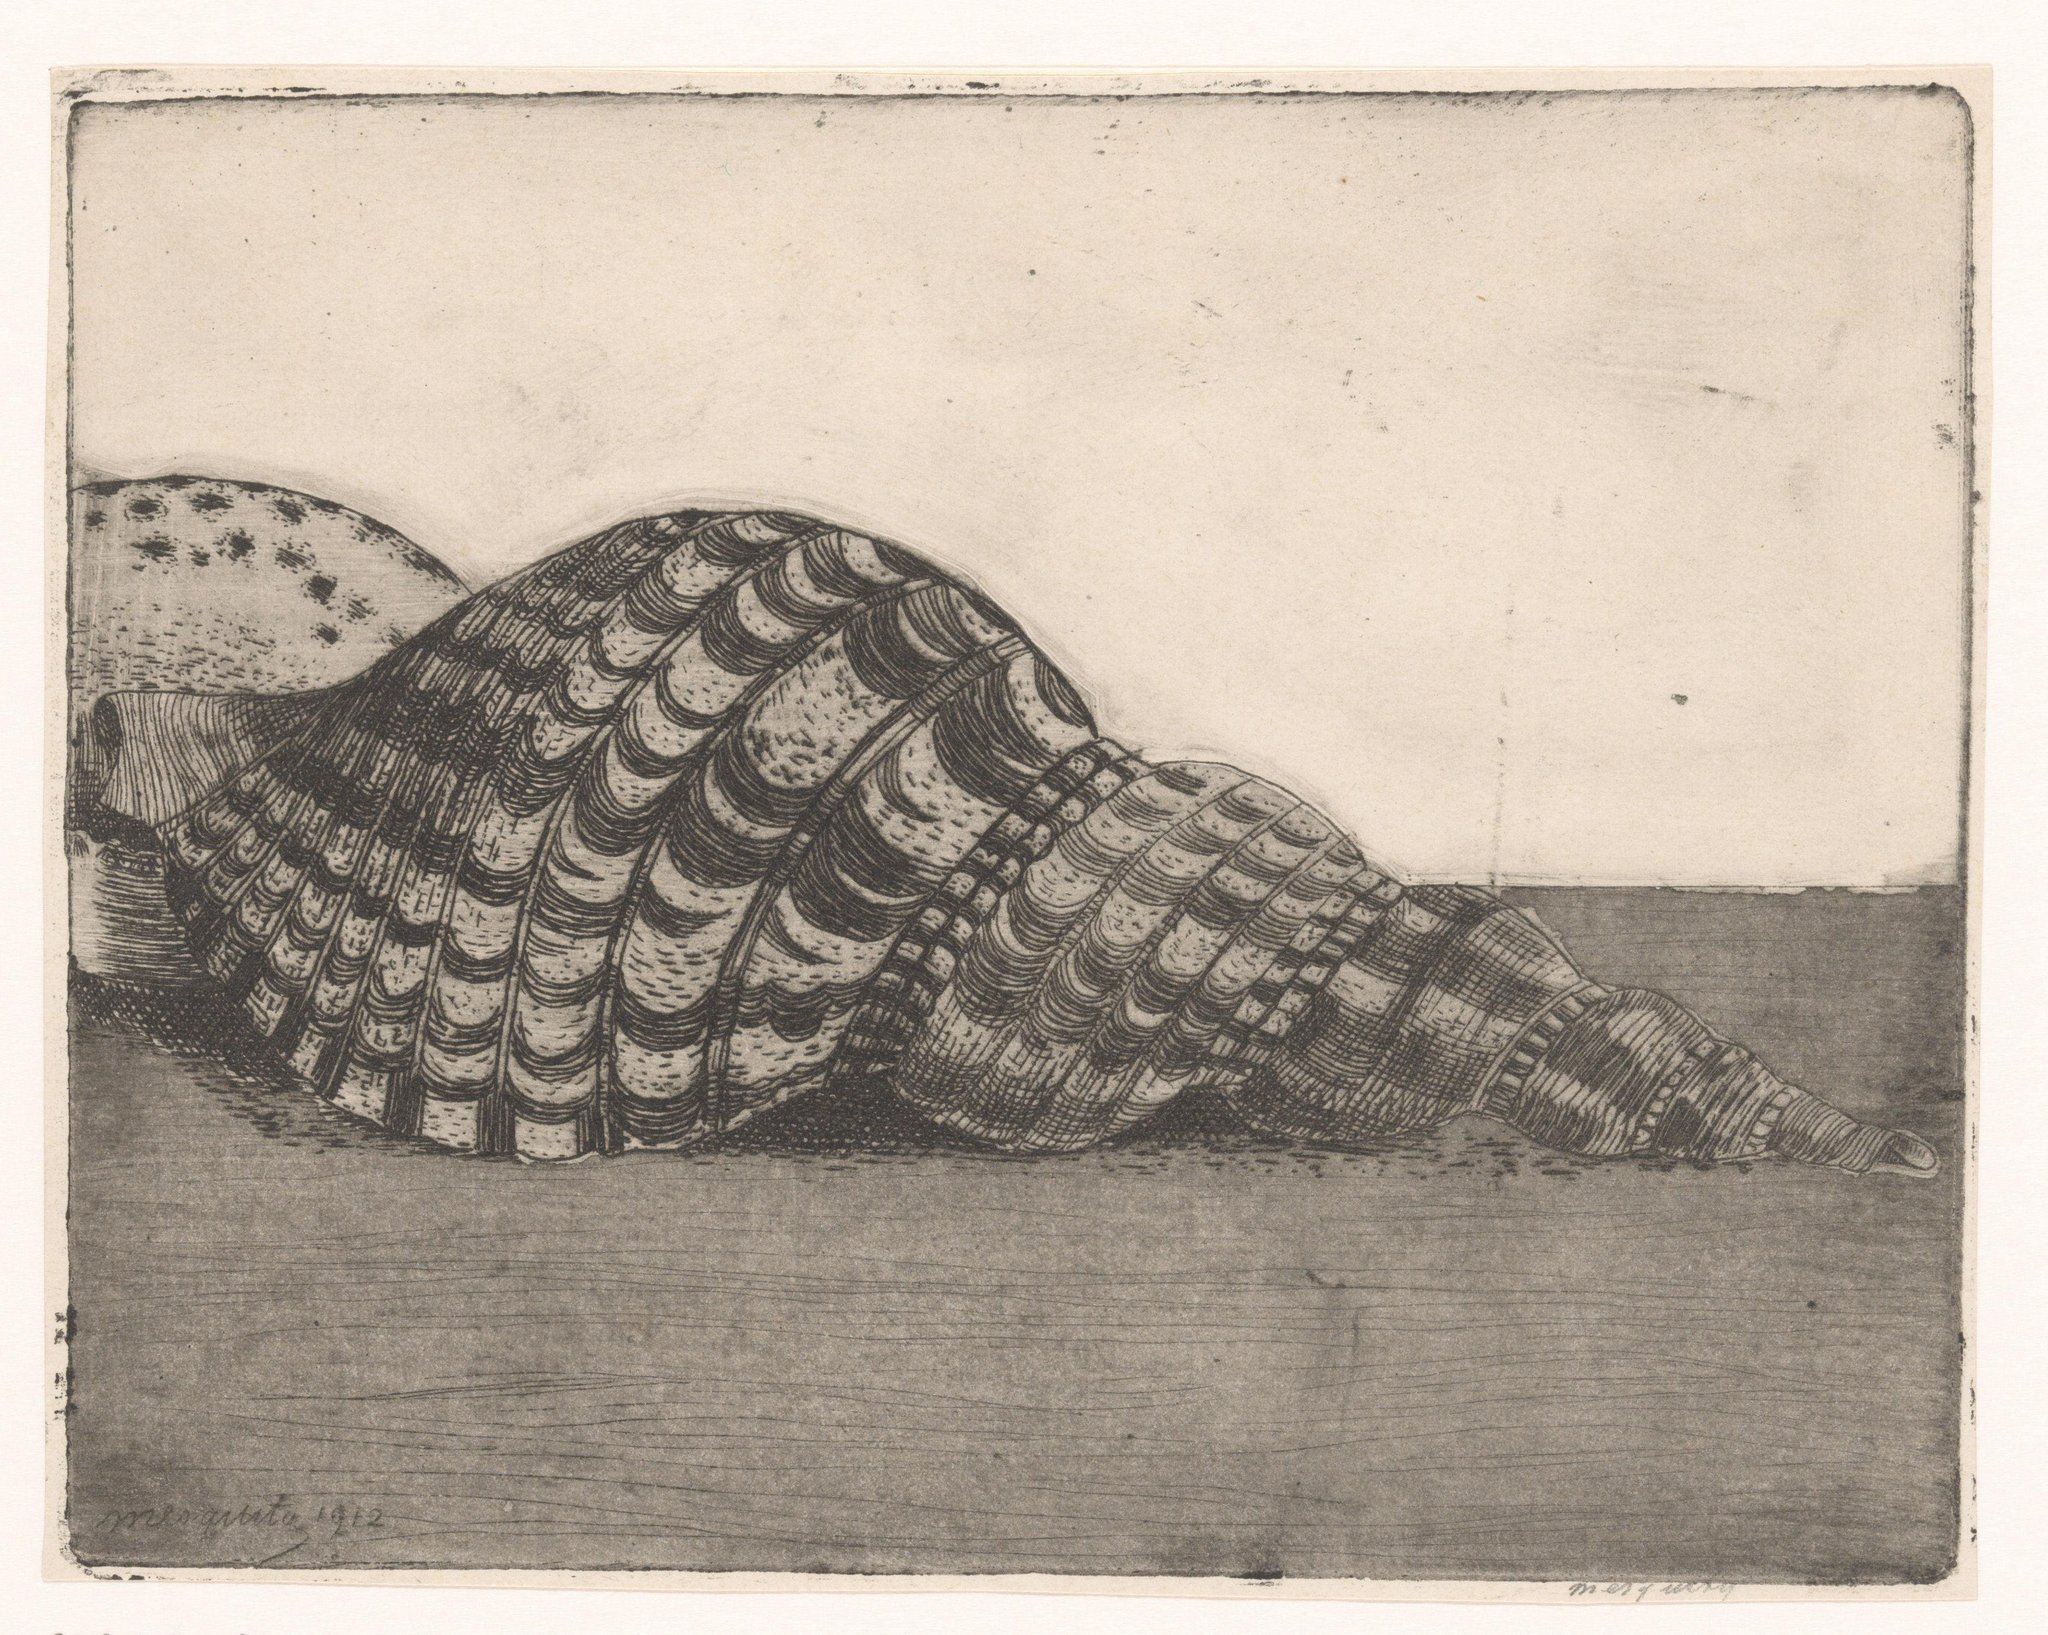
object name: print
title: Penhoren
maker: samuel jessurun de mesquita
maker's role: draughtsman, print maker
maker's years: 1868-1944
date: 1912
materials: paper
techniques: aquatint, etching, intaglio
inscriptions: collector's mark: Lugt 2228